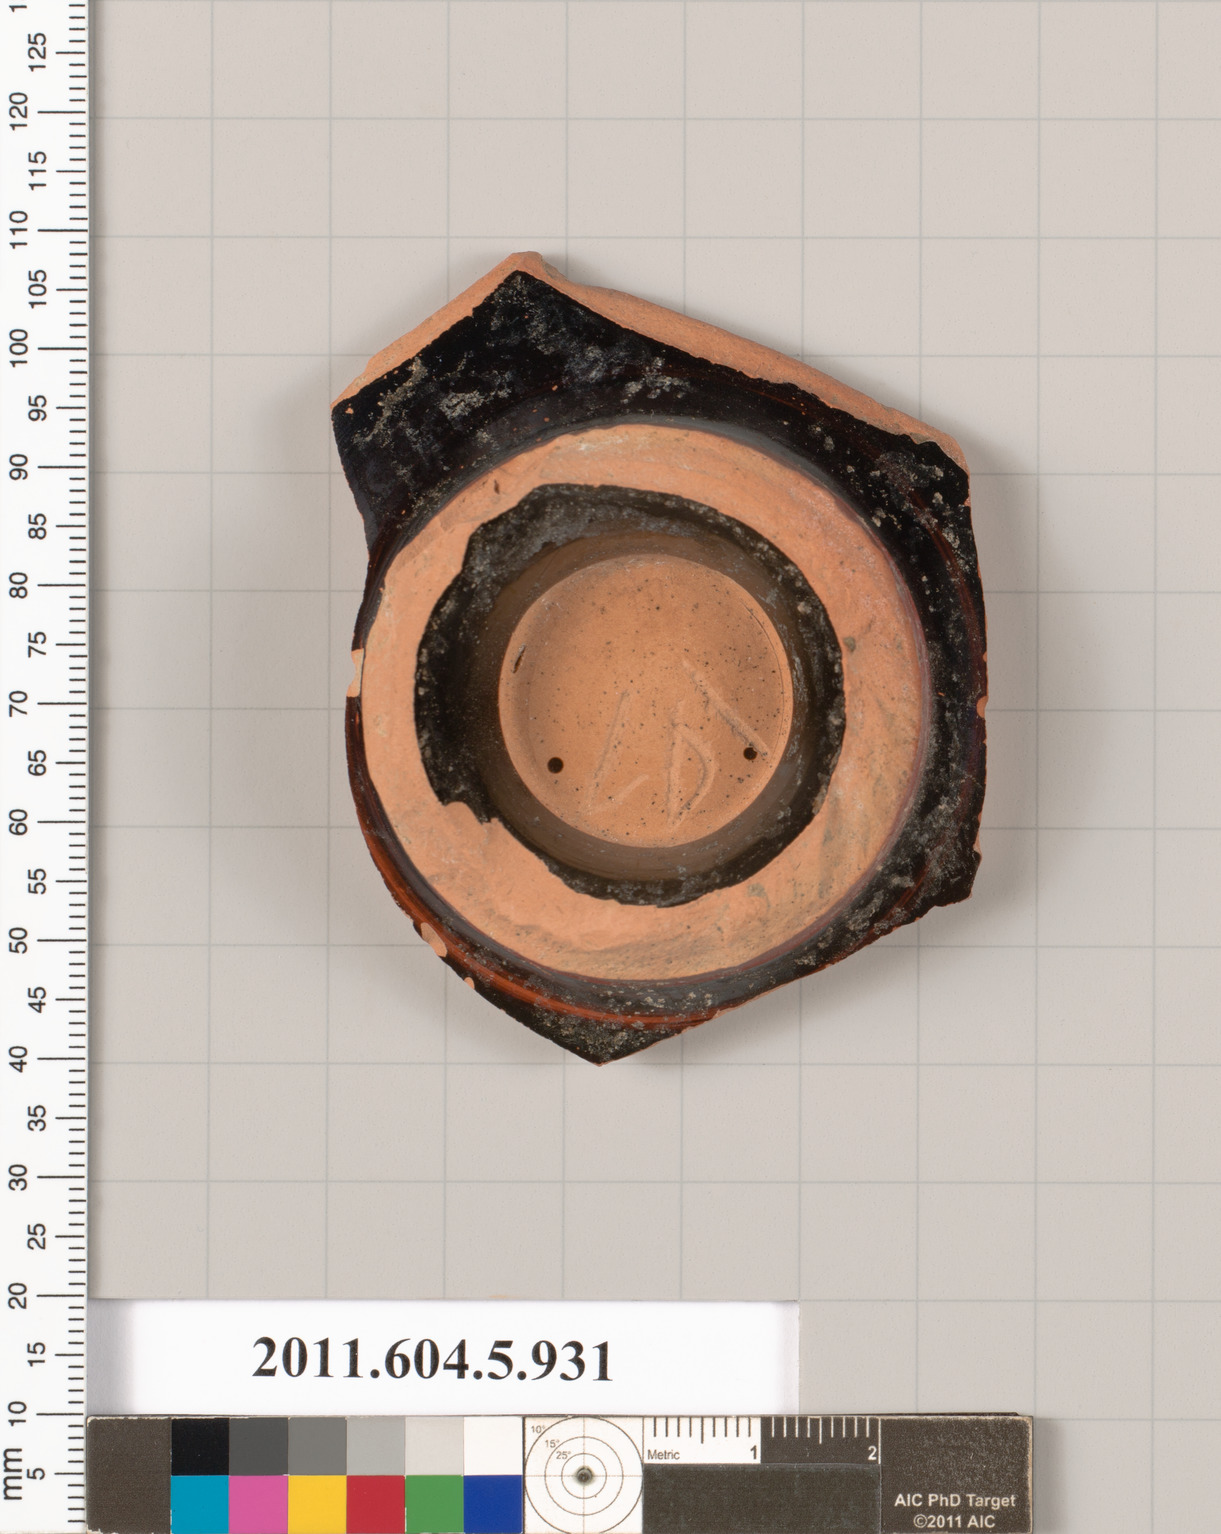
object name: kylix fragment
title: Terracotta fragment of a kylix (drinking cup)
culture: greek, attic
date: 600-401 BCE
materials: terracotta